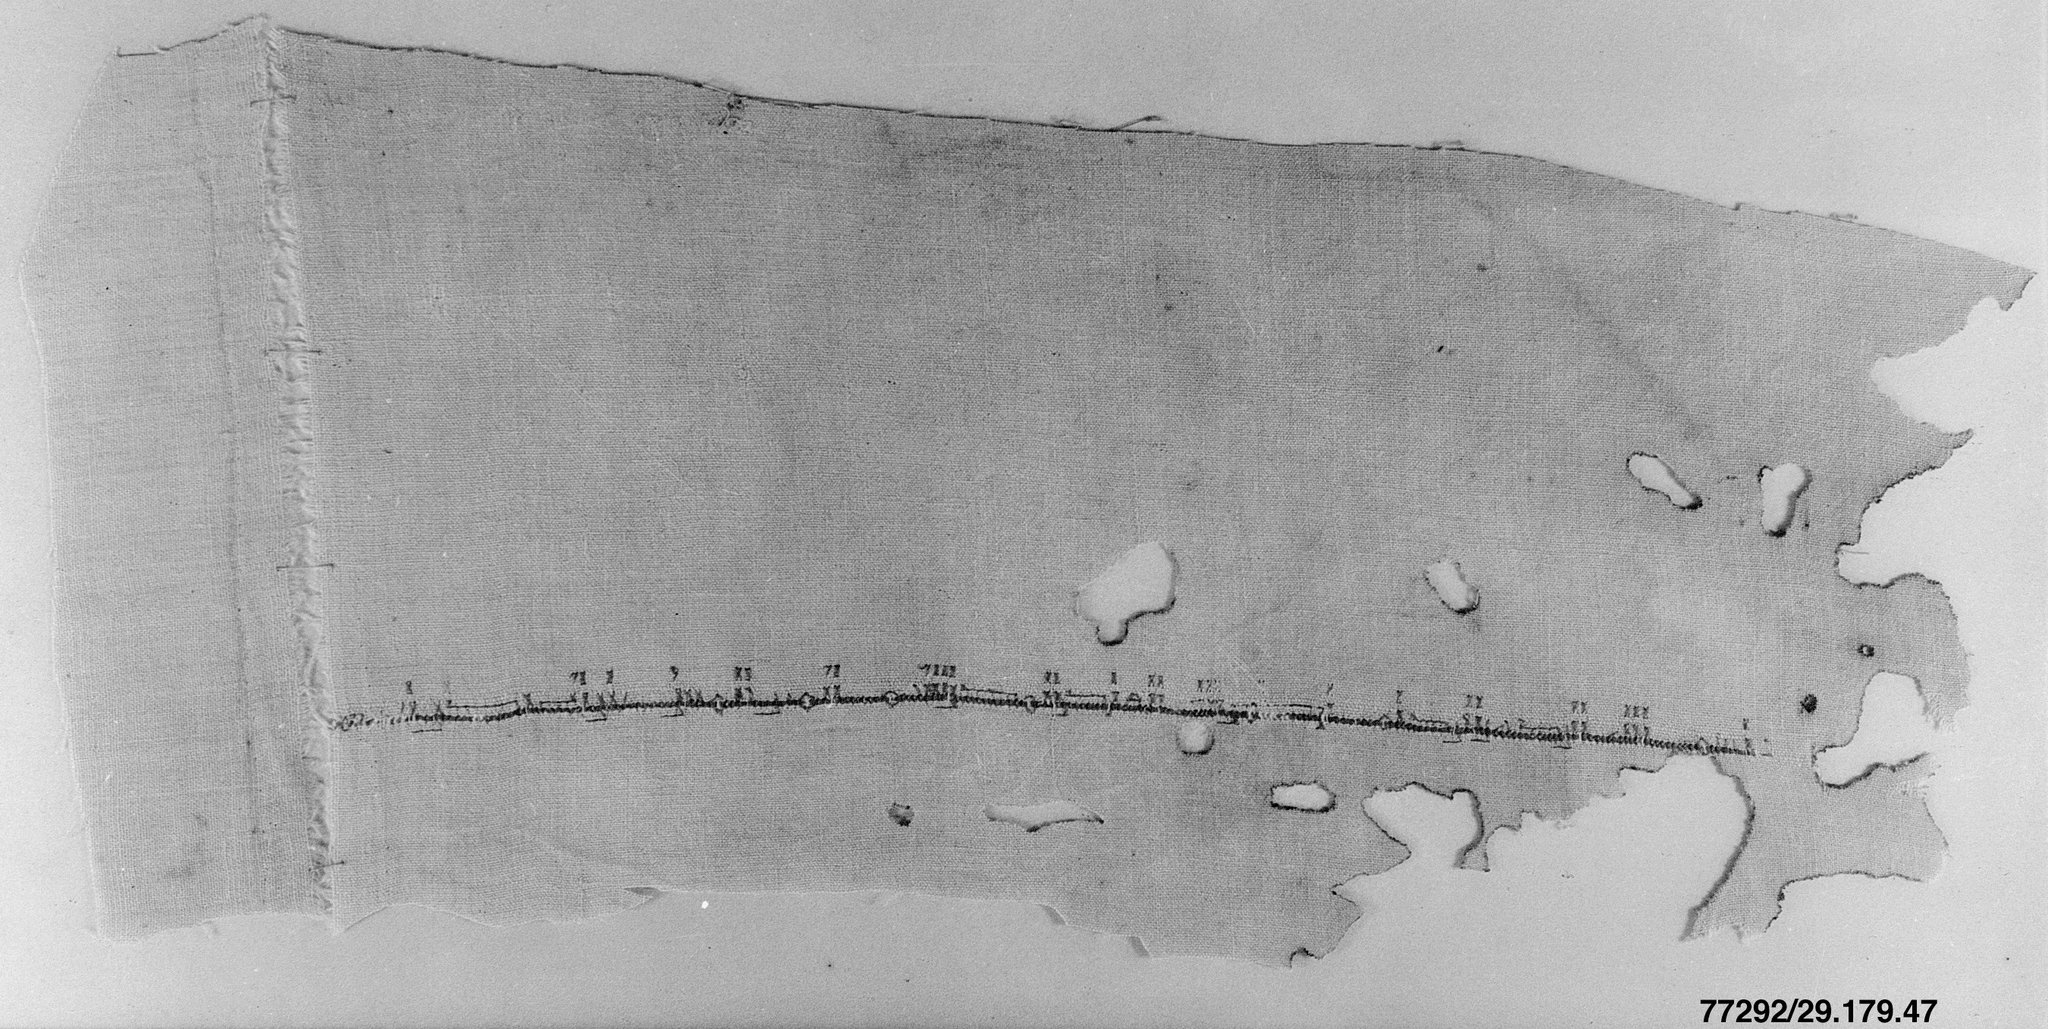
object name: textile fragment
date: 901-1000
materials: linen, silk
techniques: embroidery, weave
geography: egypt